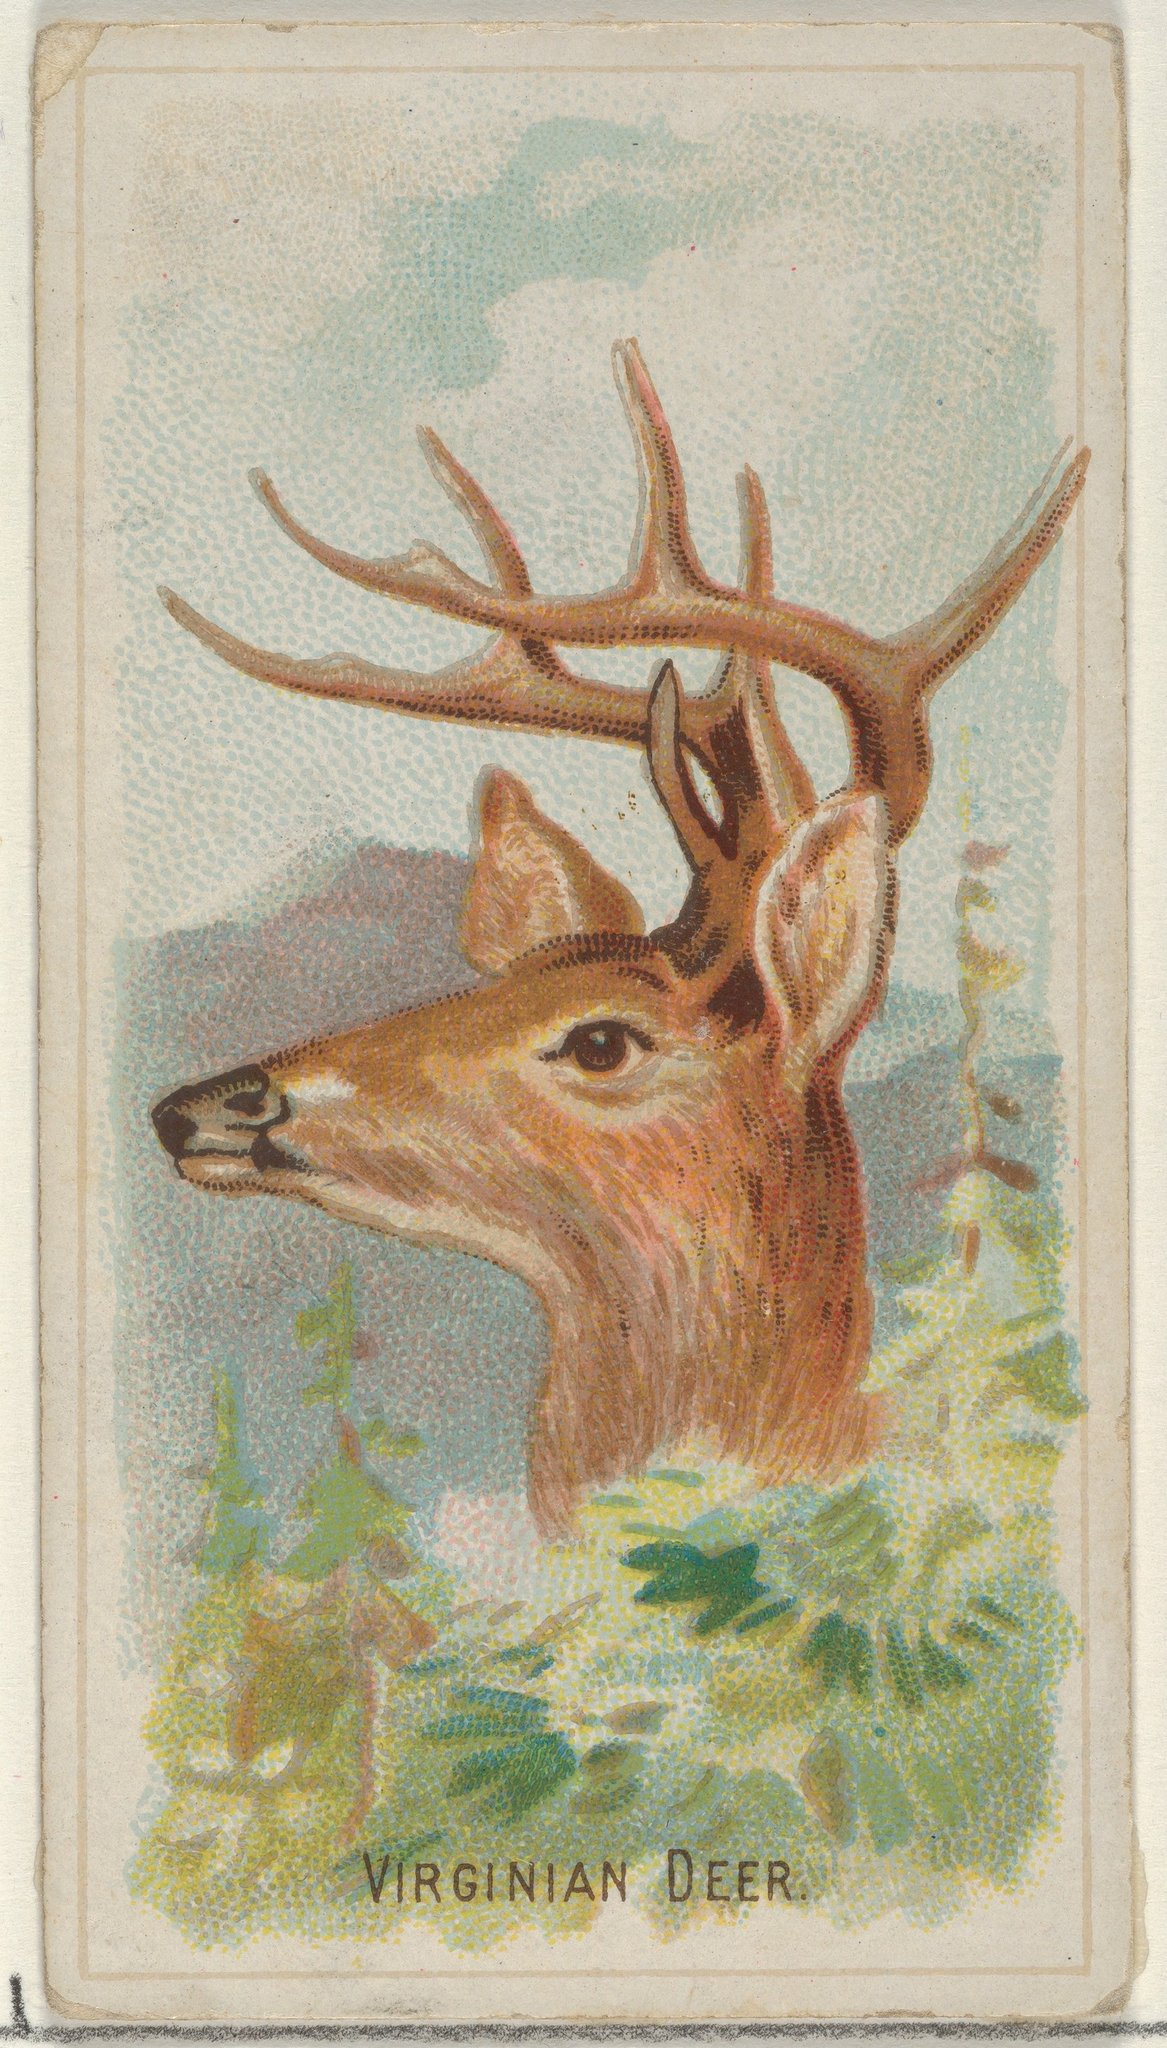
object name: print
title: Virginian Deer, from the Wild Animals of the World series (N25) for Allen & Ginter Cigarettes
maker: allen & ginter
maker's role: publisher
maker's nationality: american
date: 1888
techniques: color lithograph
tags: deer